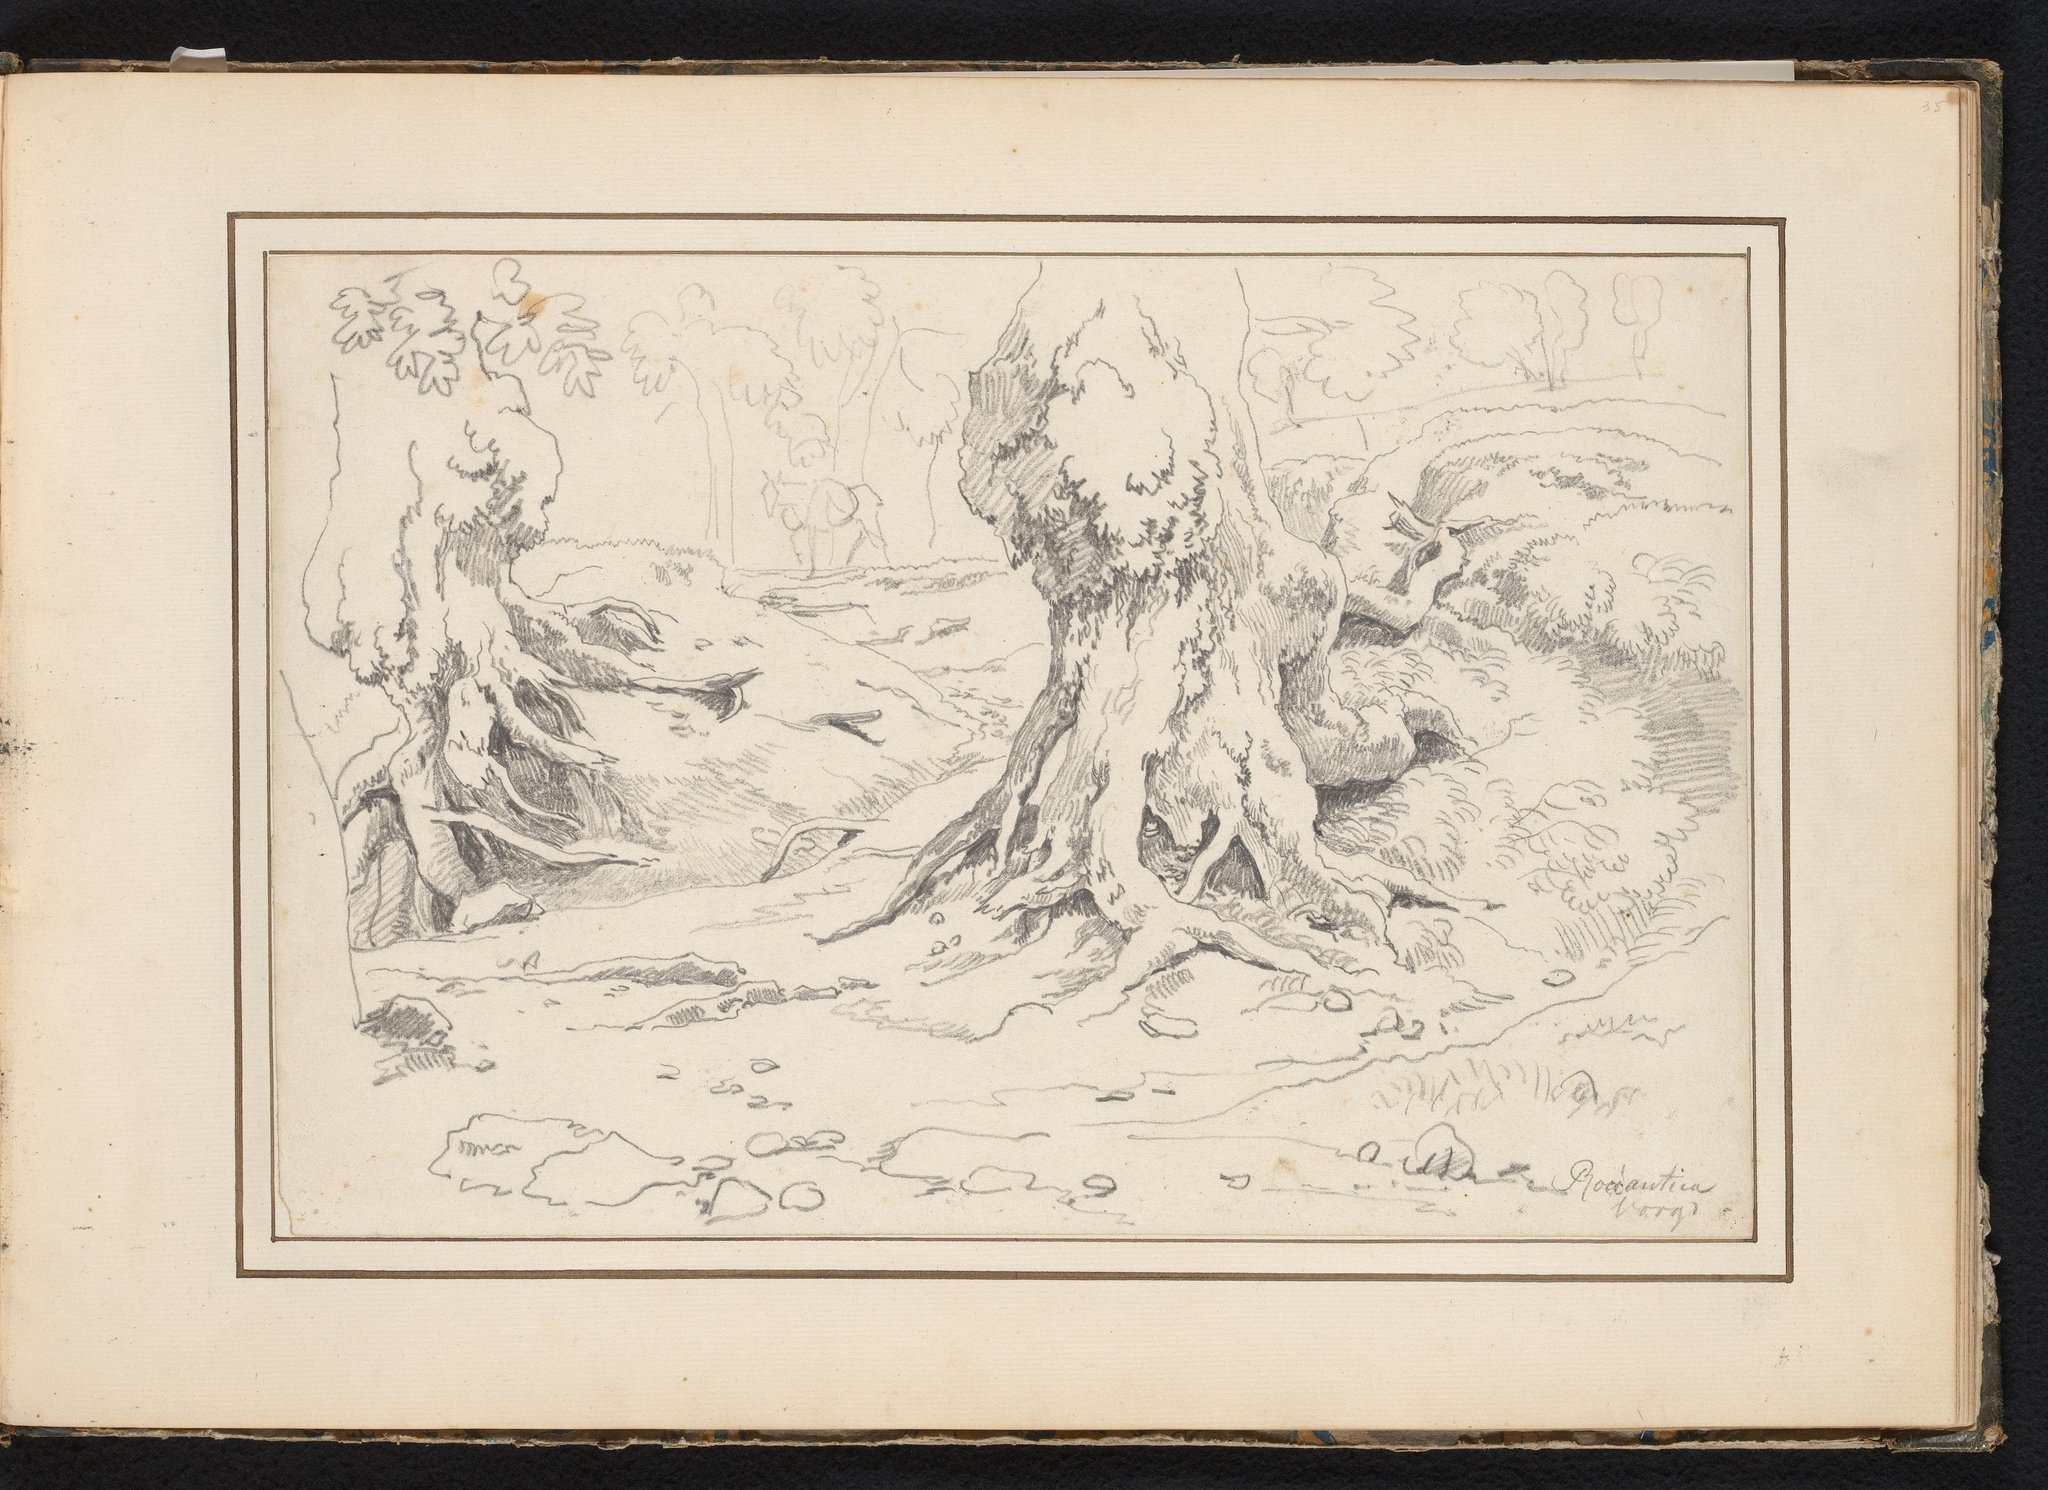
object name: album leaf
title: Landschap met bomen en boomwortels, met op de achtergrond een paard, te Roccantica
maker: hendrik voogd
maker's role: draughtsman, painter, print maker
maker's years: 1768-1839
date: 1788-1839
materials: paper, pencil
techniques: pasting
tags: forest, wood, animal mounts; pack-animals, roccantica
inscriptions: inscription: ‘Rocc'antica’